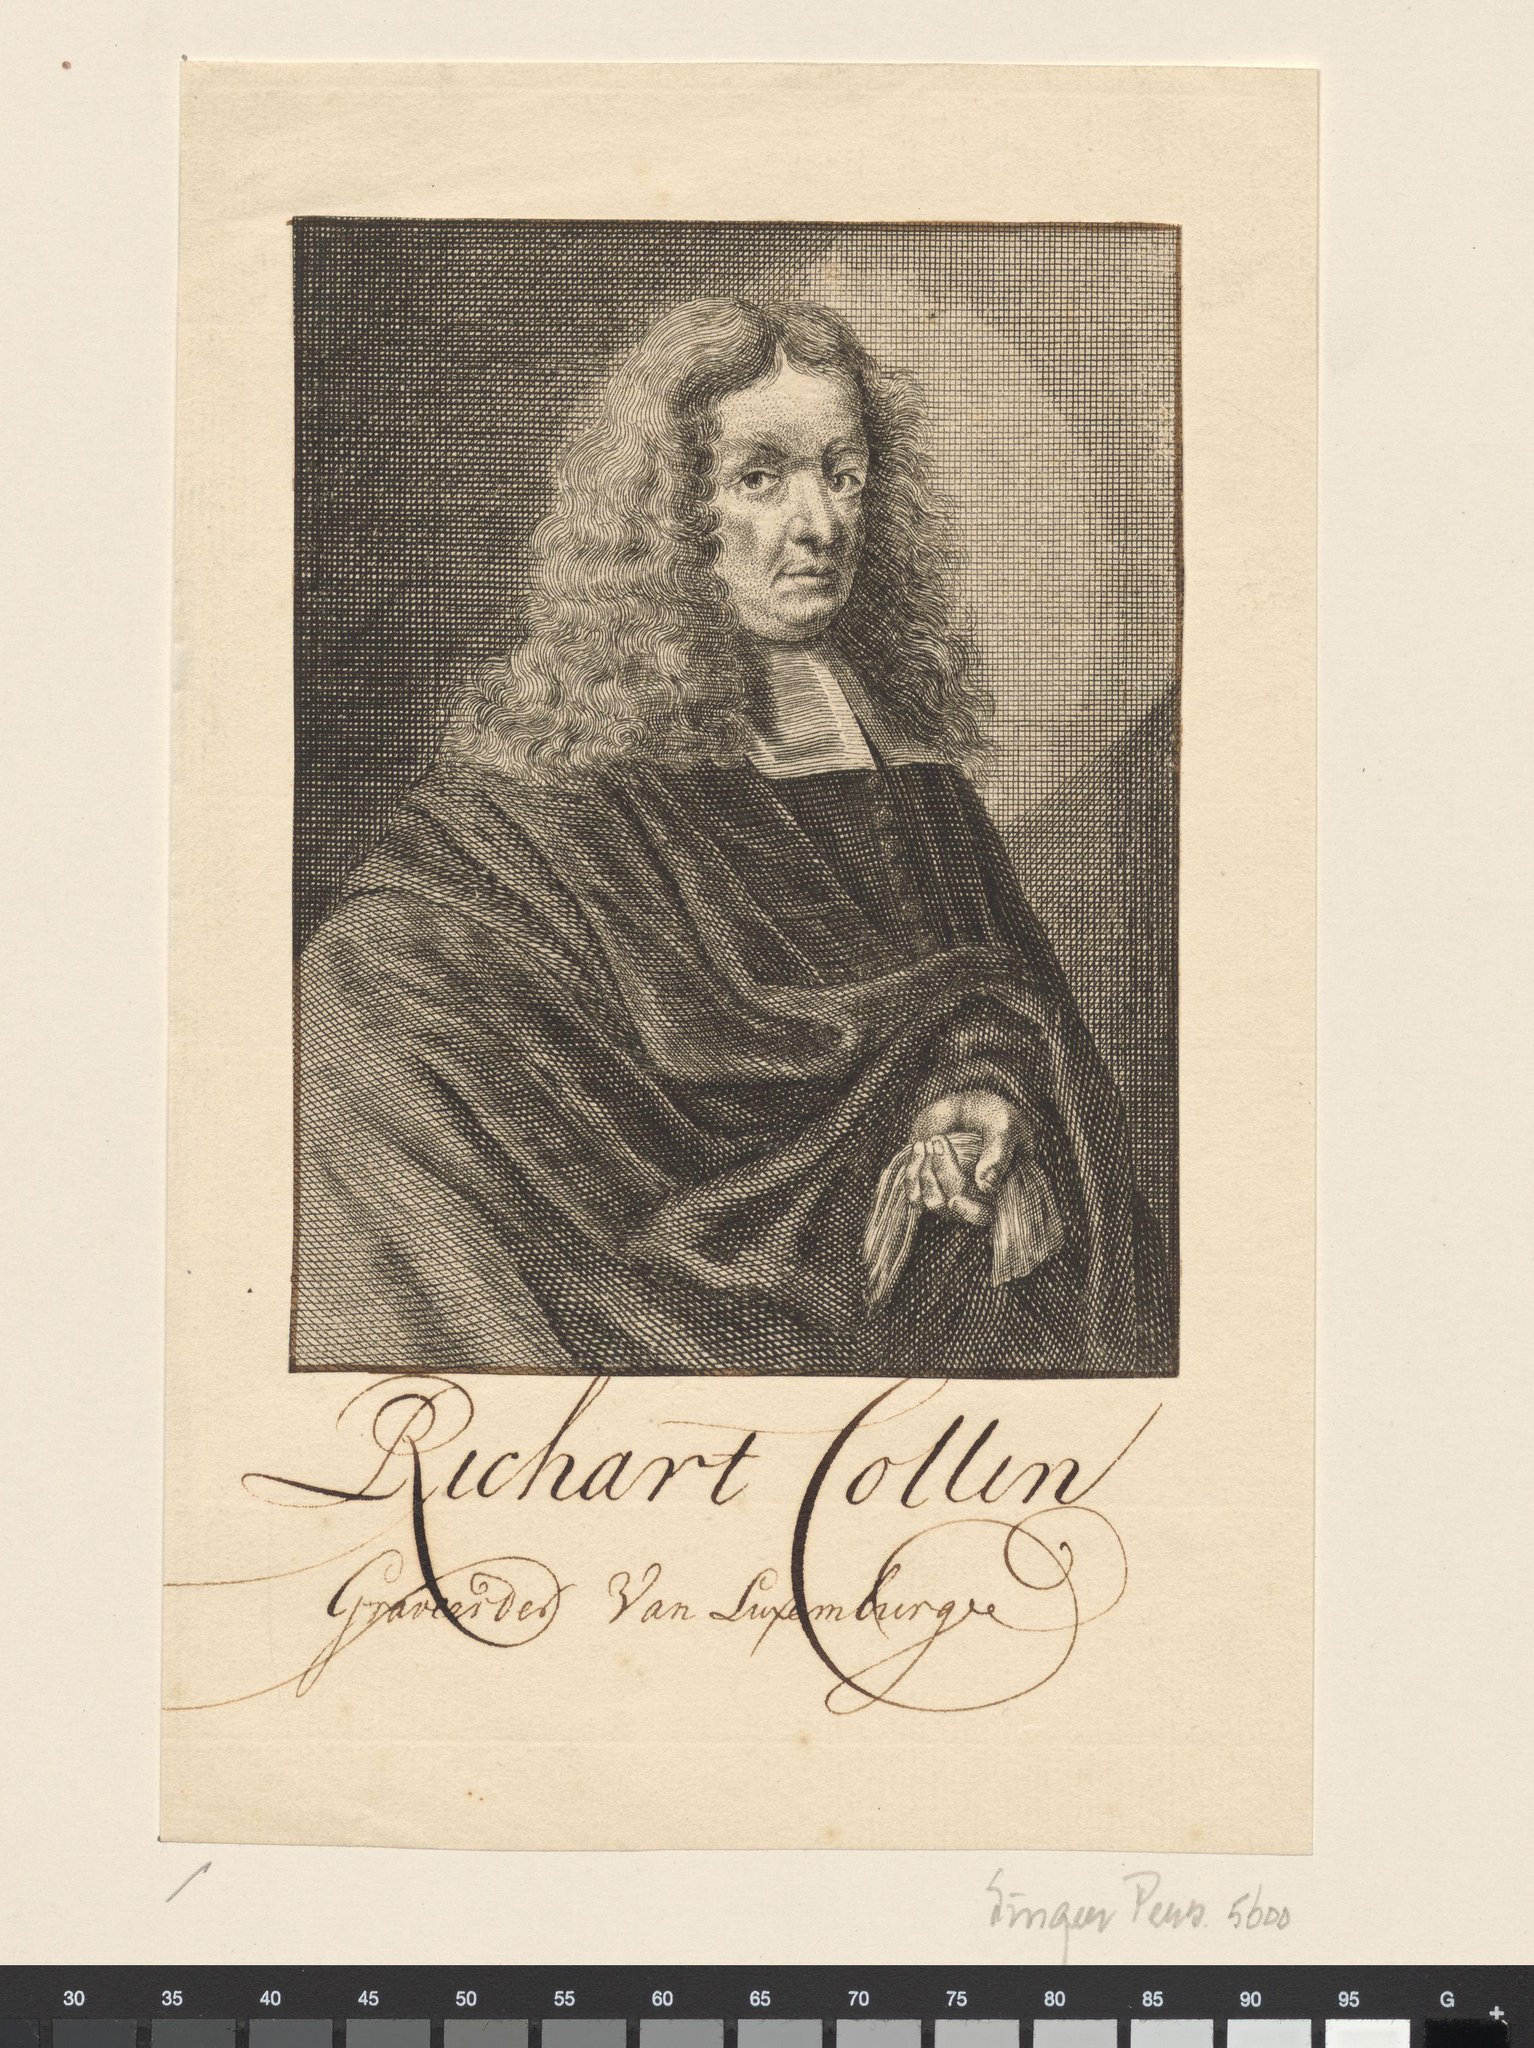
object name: print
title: Portret van Richard Collin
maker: Anonymous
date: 1660-1699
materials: paper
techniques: engraving, etching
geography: germany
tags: brussels, print maker, richard collin, historical persons, portrait, self-portrait of graphic artist